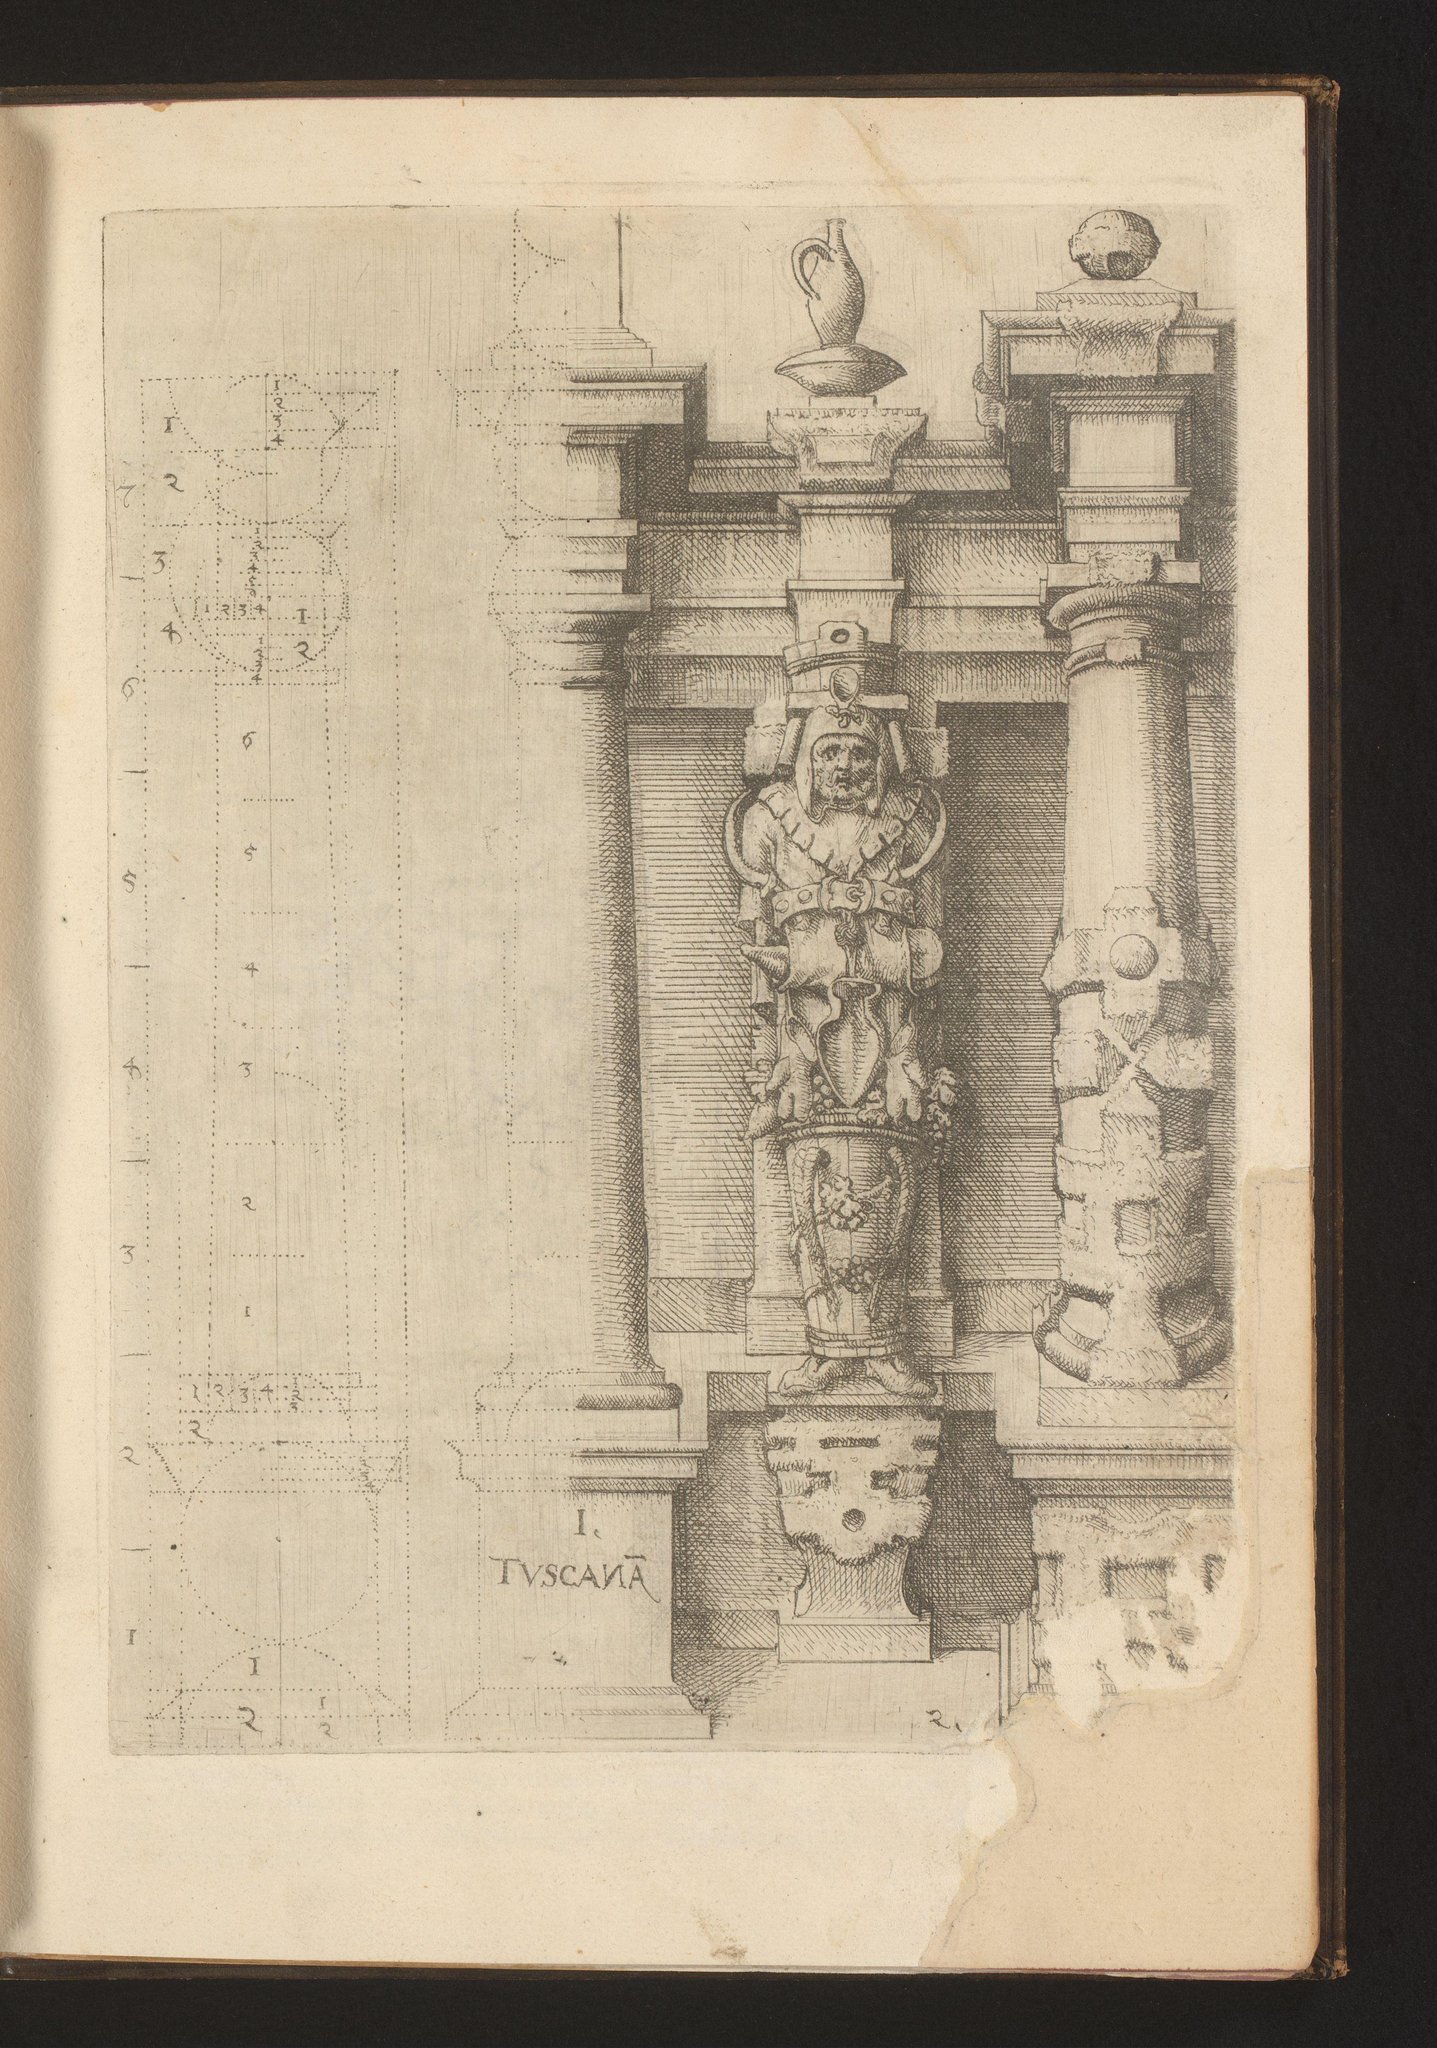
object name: ornament print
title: Architectura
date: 1593-1595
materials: paper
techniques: etching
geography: straatsburg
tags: atlantes ~ architecture, column, pillar ~ architecture, tuscan order ~ architecture, pedestal of a piece of sculpture (perhaps in the form of a herm) (+ architecture)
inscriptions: collector's mark: Lugt 2228, collector's mark: Lugt 2760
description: Prent gebruikt in: Dietterlin, Wendel (I). Architectura de quinq[ue] columnarum simmetrica distributione et variis eorundem or namentis: Liber I. Straatsburg: Bernhard Jobin, 1593. Het verso van deze prent bevat nog een afdruk van deze plaat.